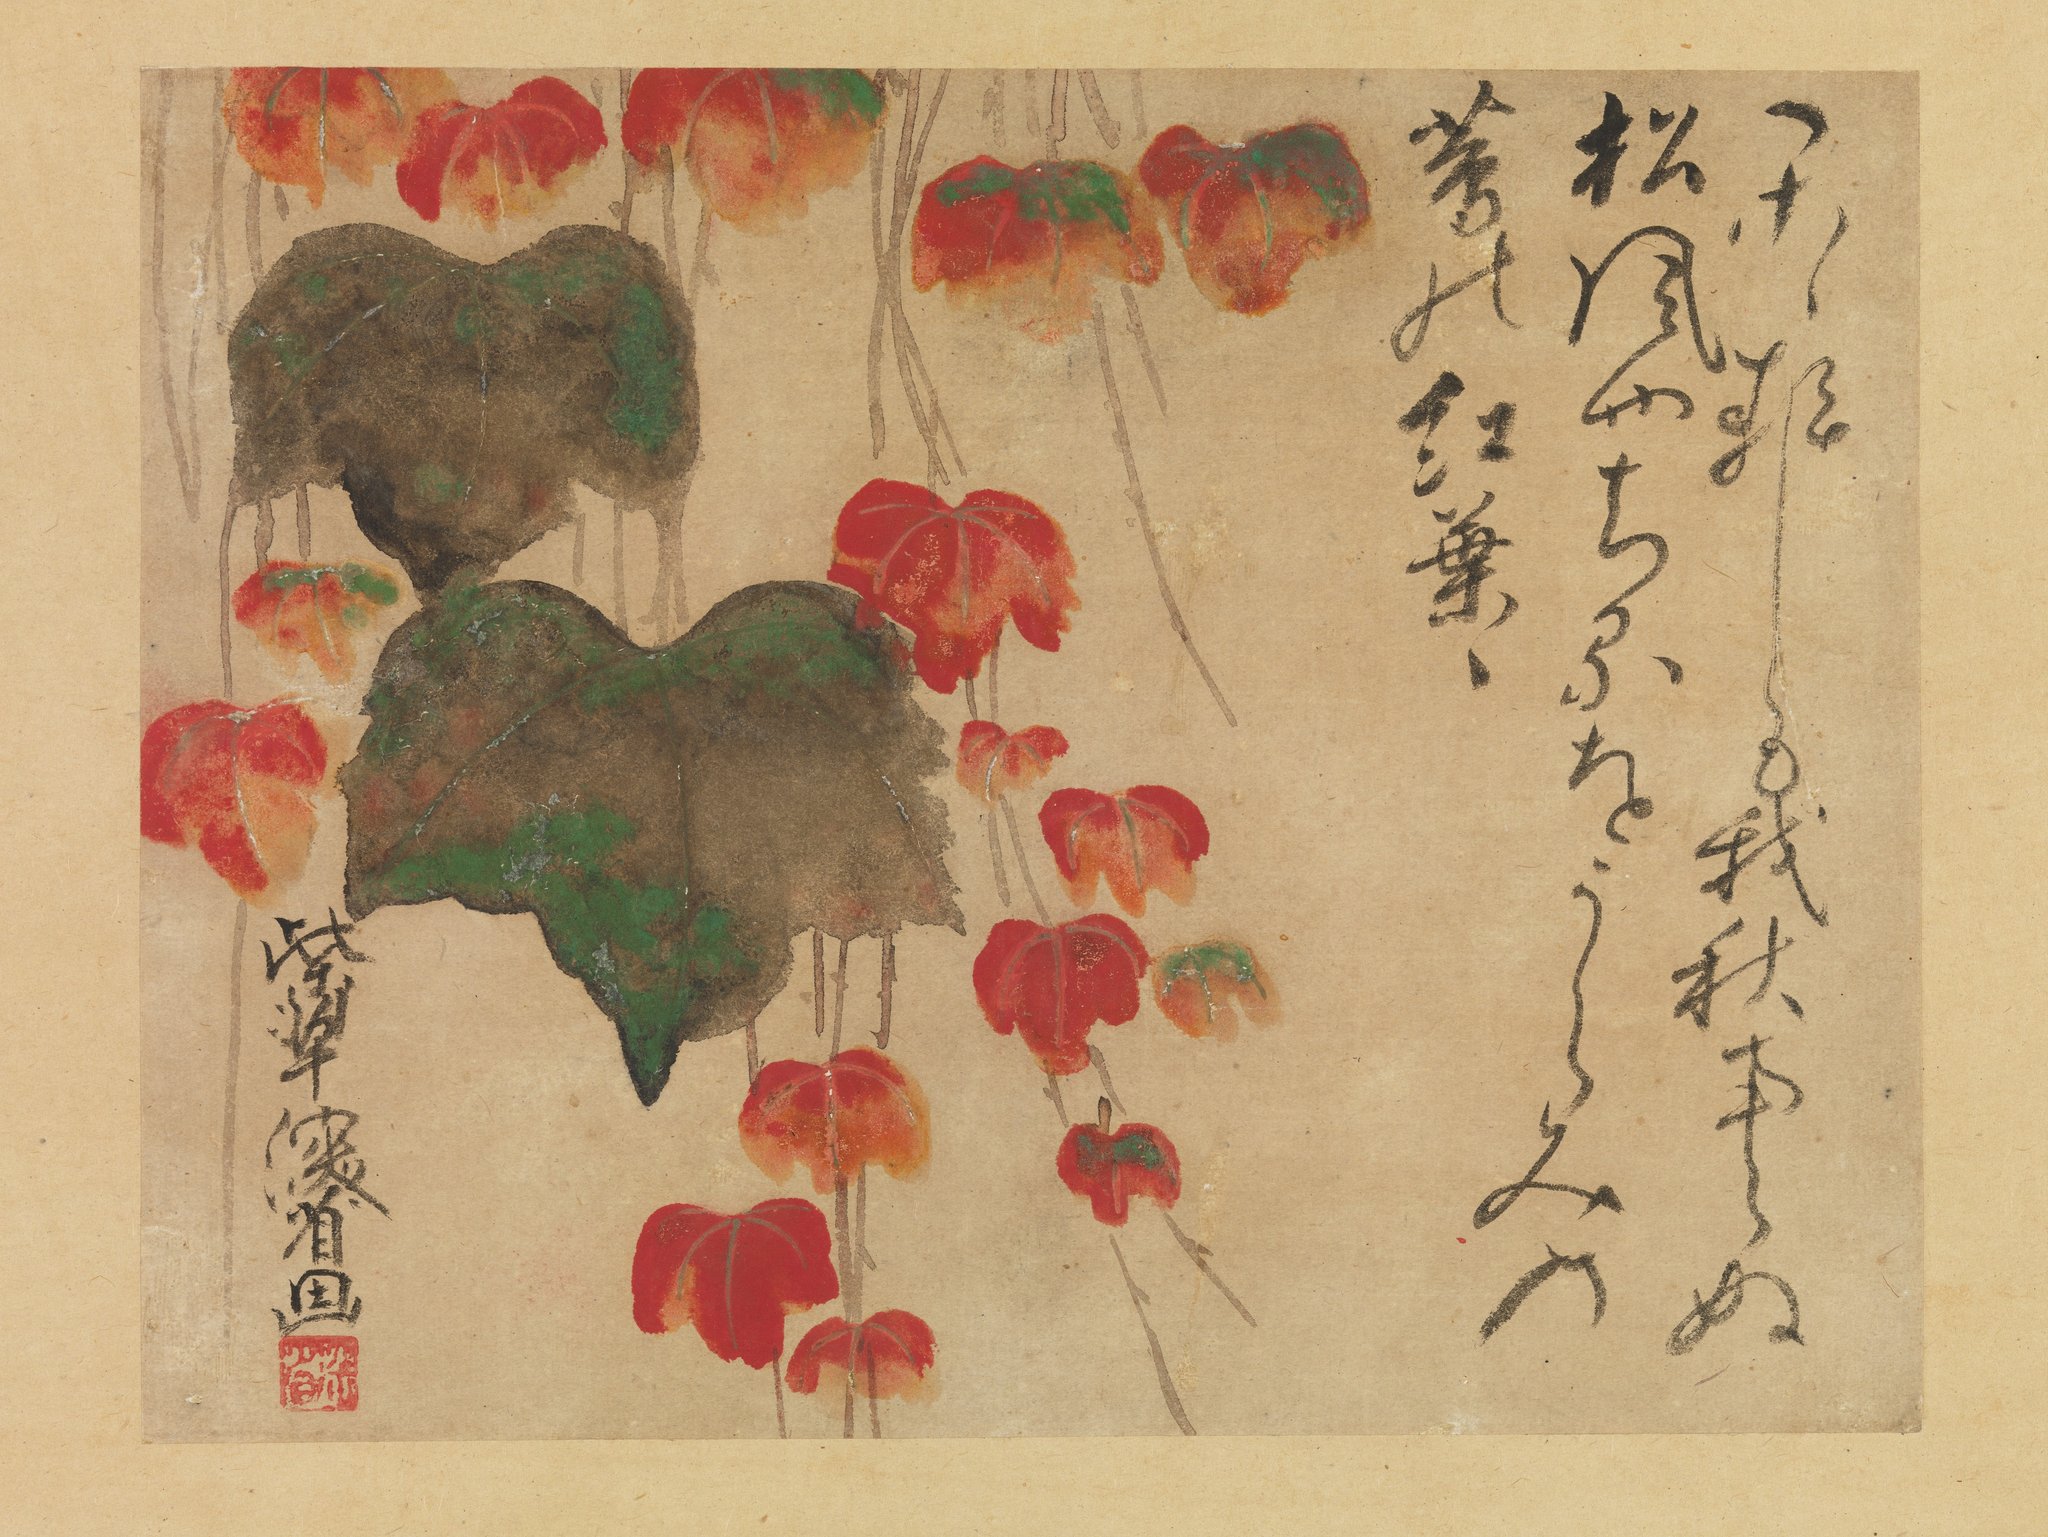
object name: hanging scroll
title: Autumn Ivy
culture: japanese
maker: ogata kenzan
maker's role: artist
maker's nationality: japanese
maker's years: 1663-1743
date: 1732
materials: gold, ink, paper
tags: leaves